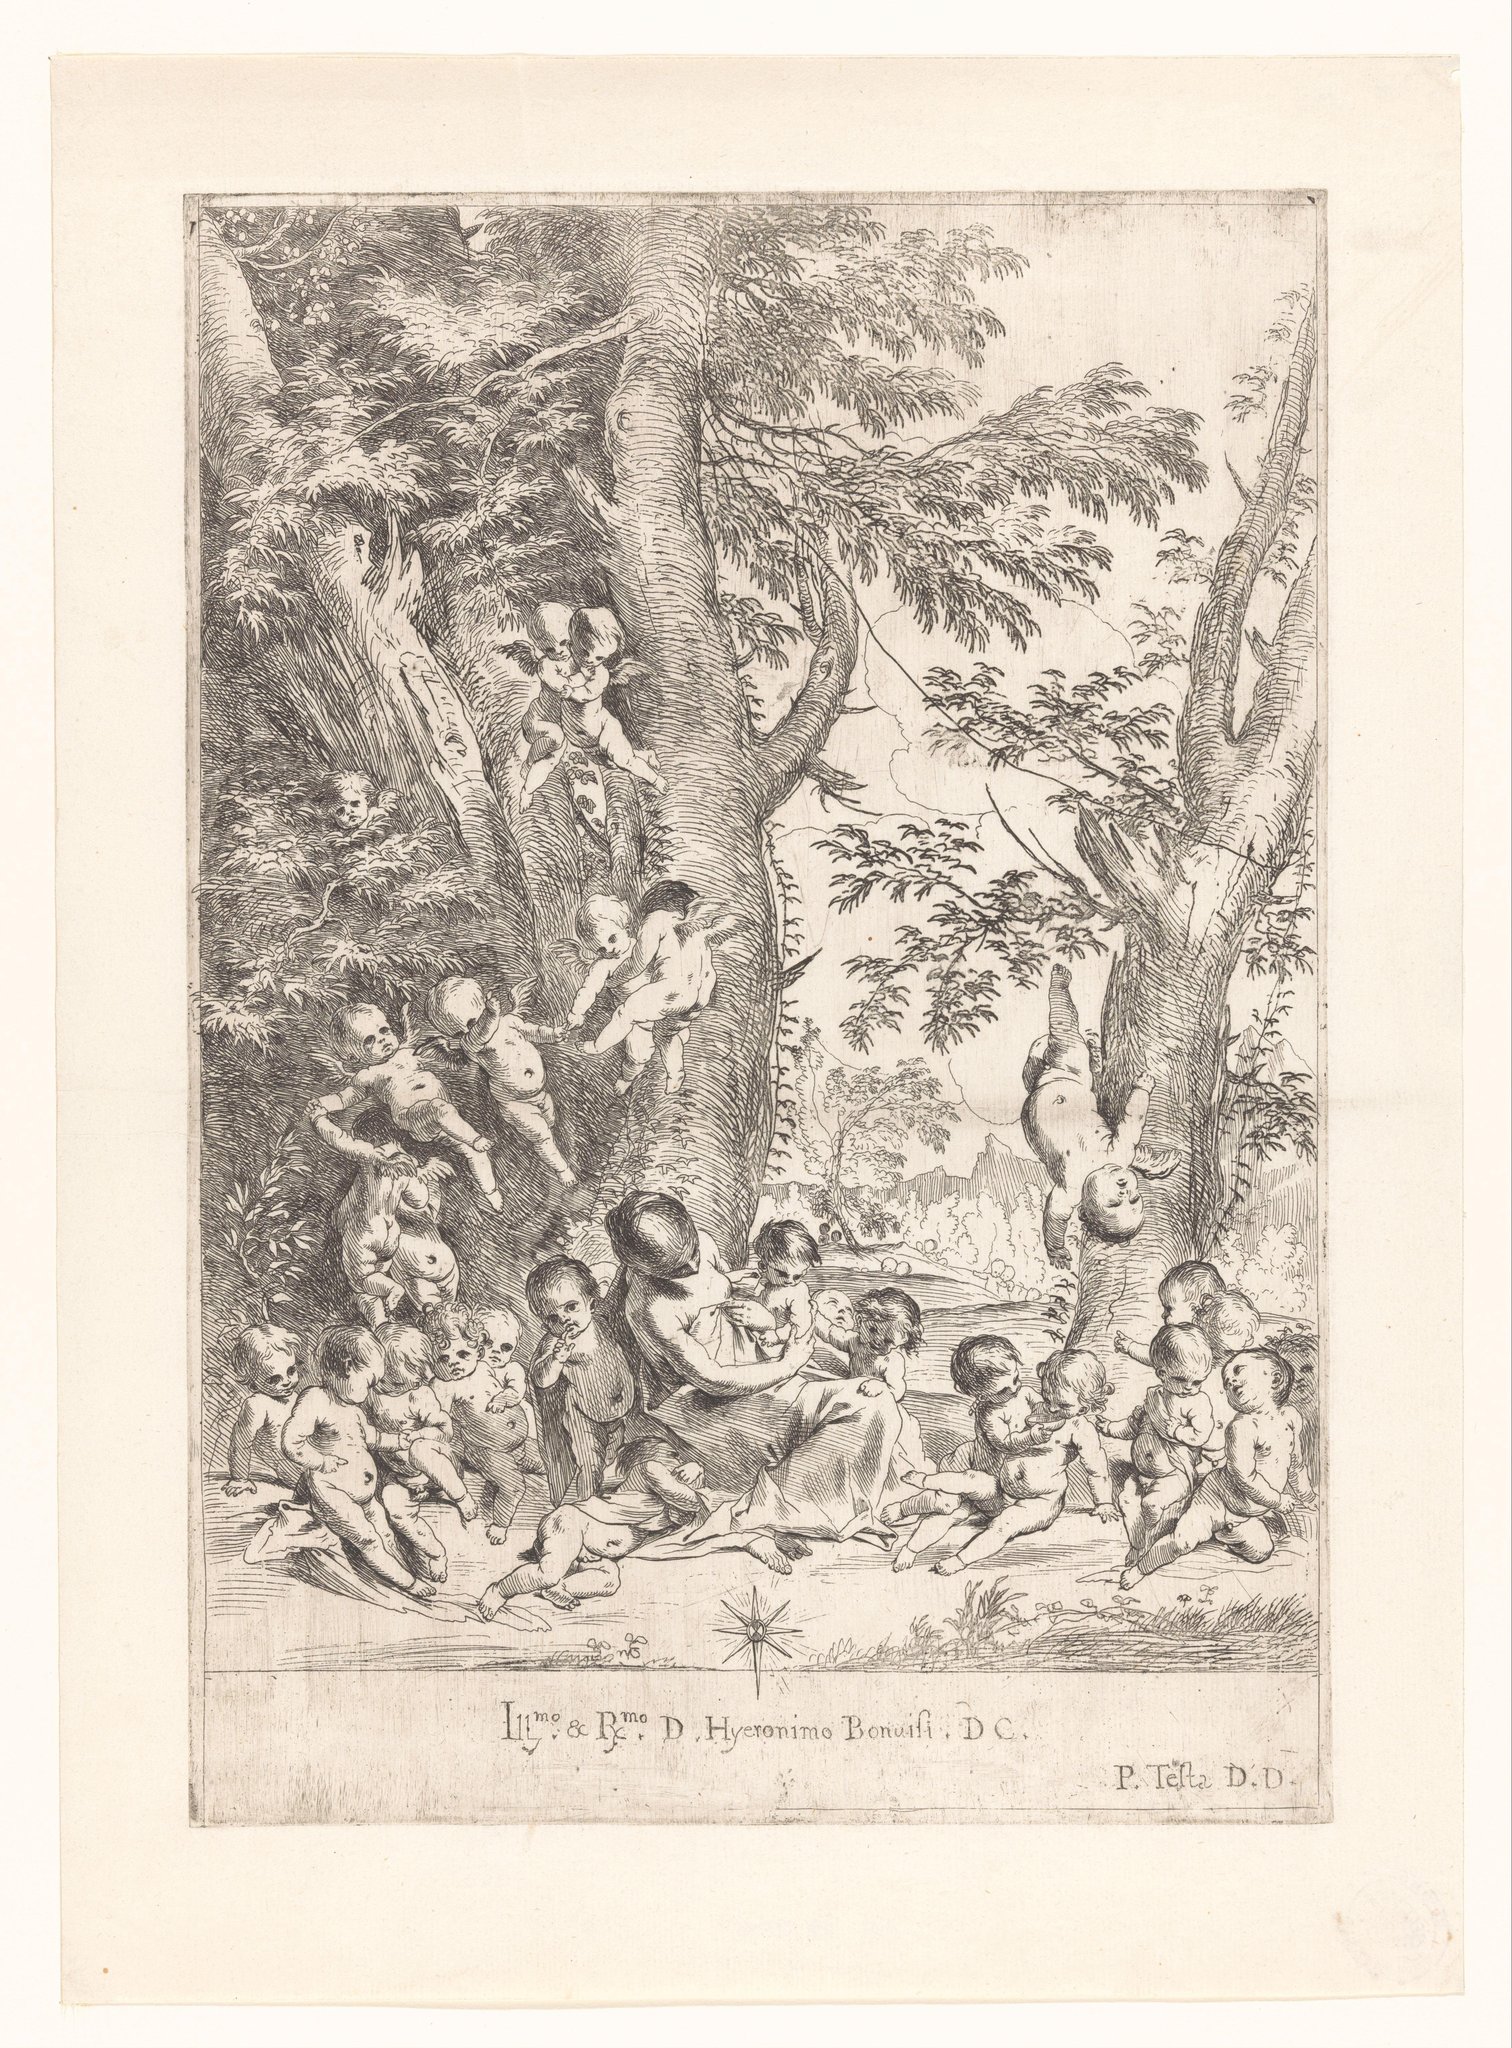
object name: print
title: Tuin van Caritas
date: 1630-1631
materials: paper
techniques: etching, intaglio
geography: italy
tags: charity, 'caritas'; 'carità' (ripa) ~ one of the three theological virtues, cupids: 'amores', 'amoretti', 'putti'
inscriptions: collector's mark: Lugt 240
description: Een personificatie van de liefde (Caritas), zittend in een tuin en omgeven door putti. Rechts hangt een putto ondersteboven in een boom. Opdracht in ondermarge.